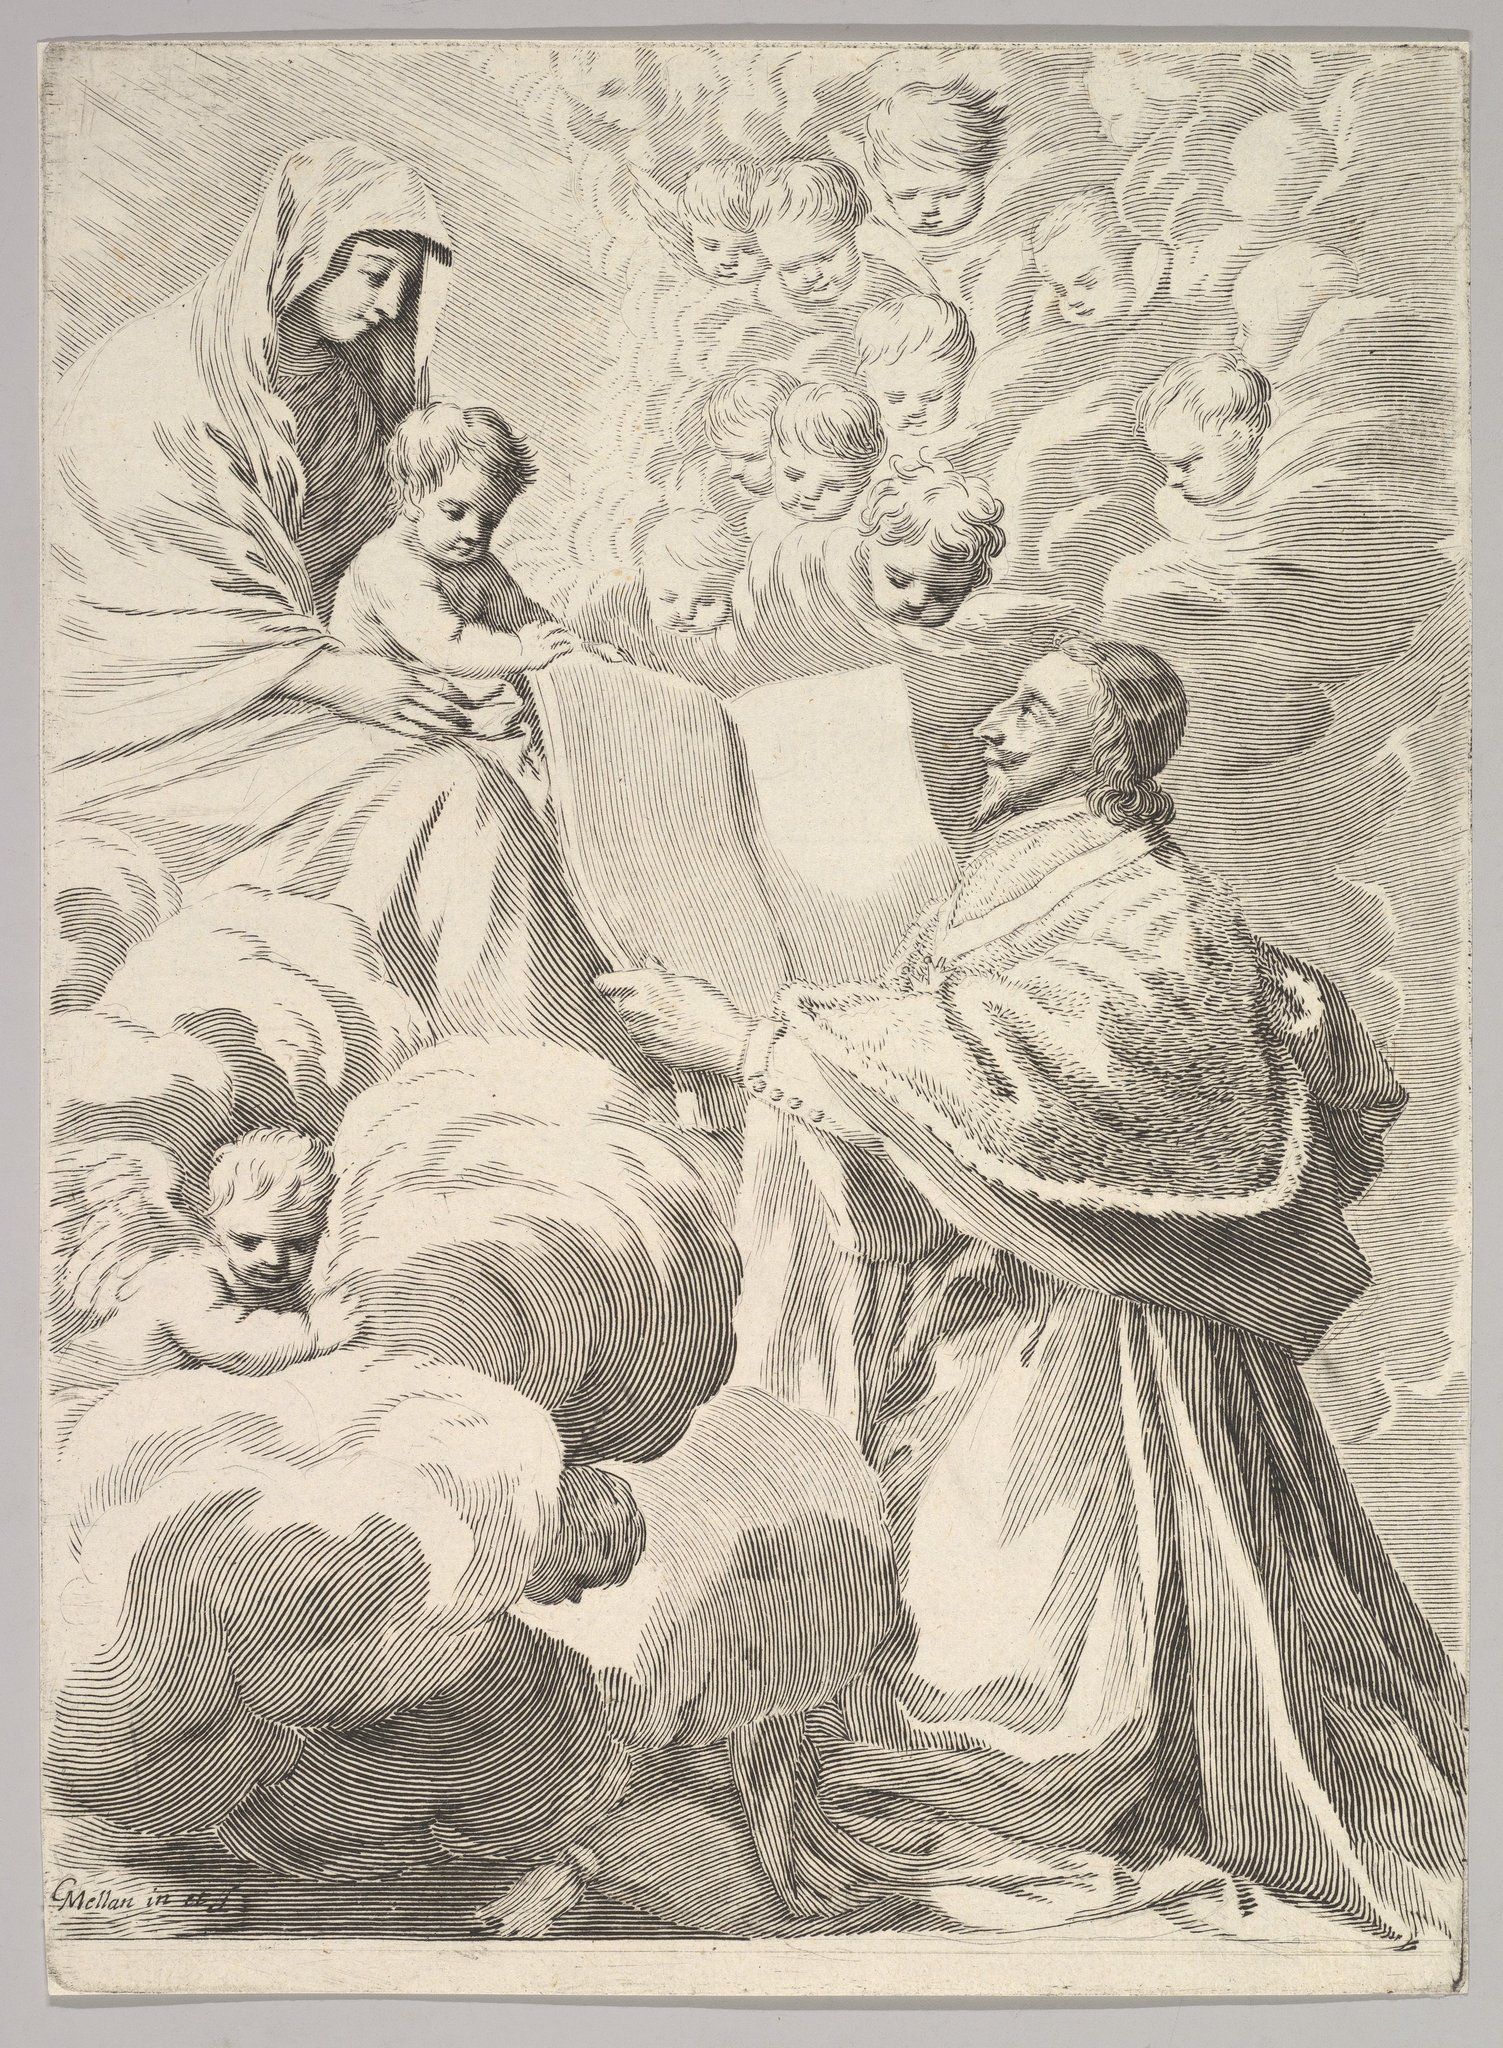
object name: print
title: Cardinal Richelieu, Kneeling, Presents His Book to the Virgin and Child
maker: claude mellan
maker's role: artist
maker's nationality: french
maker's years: 1598-1688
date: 1646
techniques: engraving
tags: books,men,angels,madonna and child